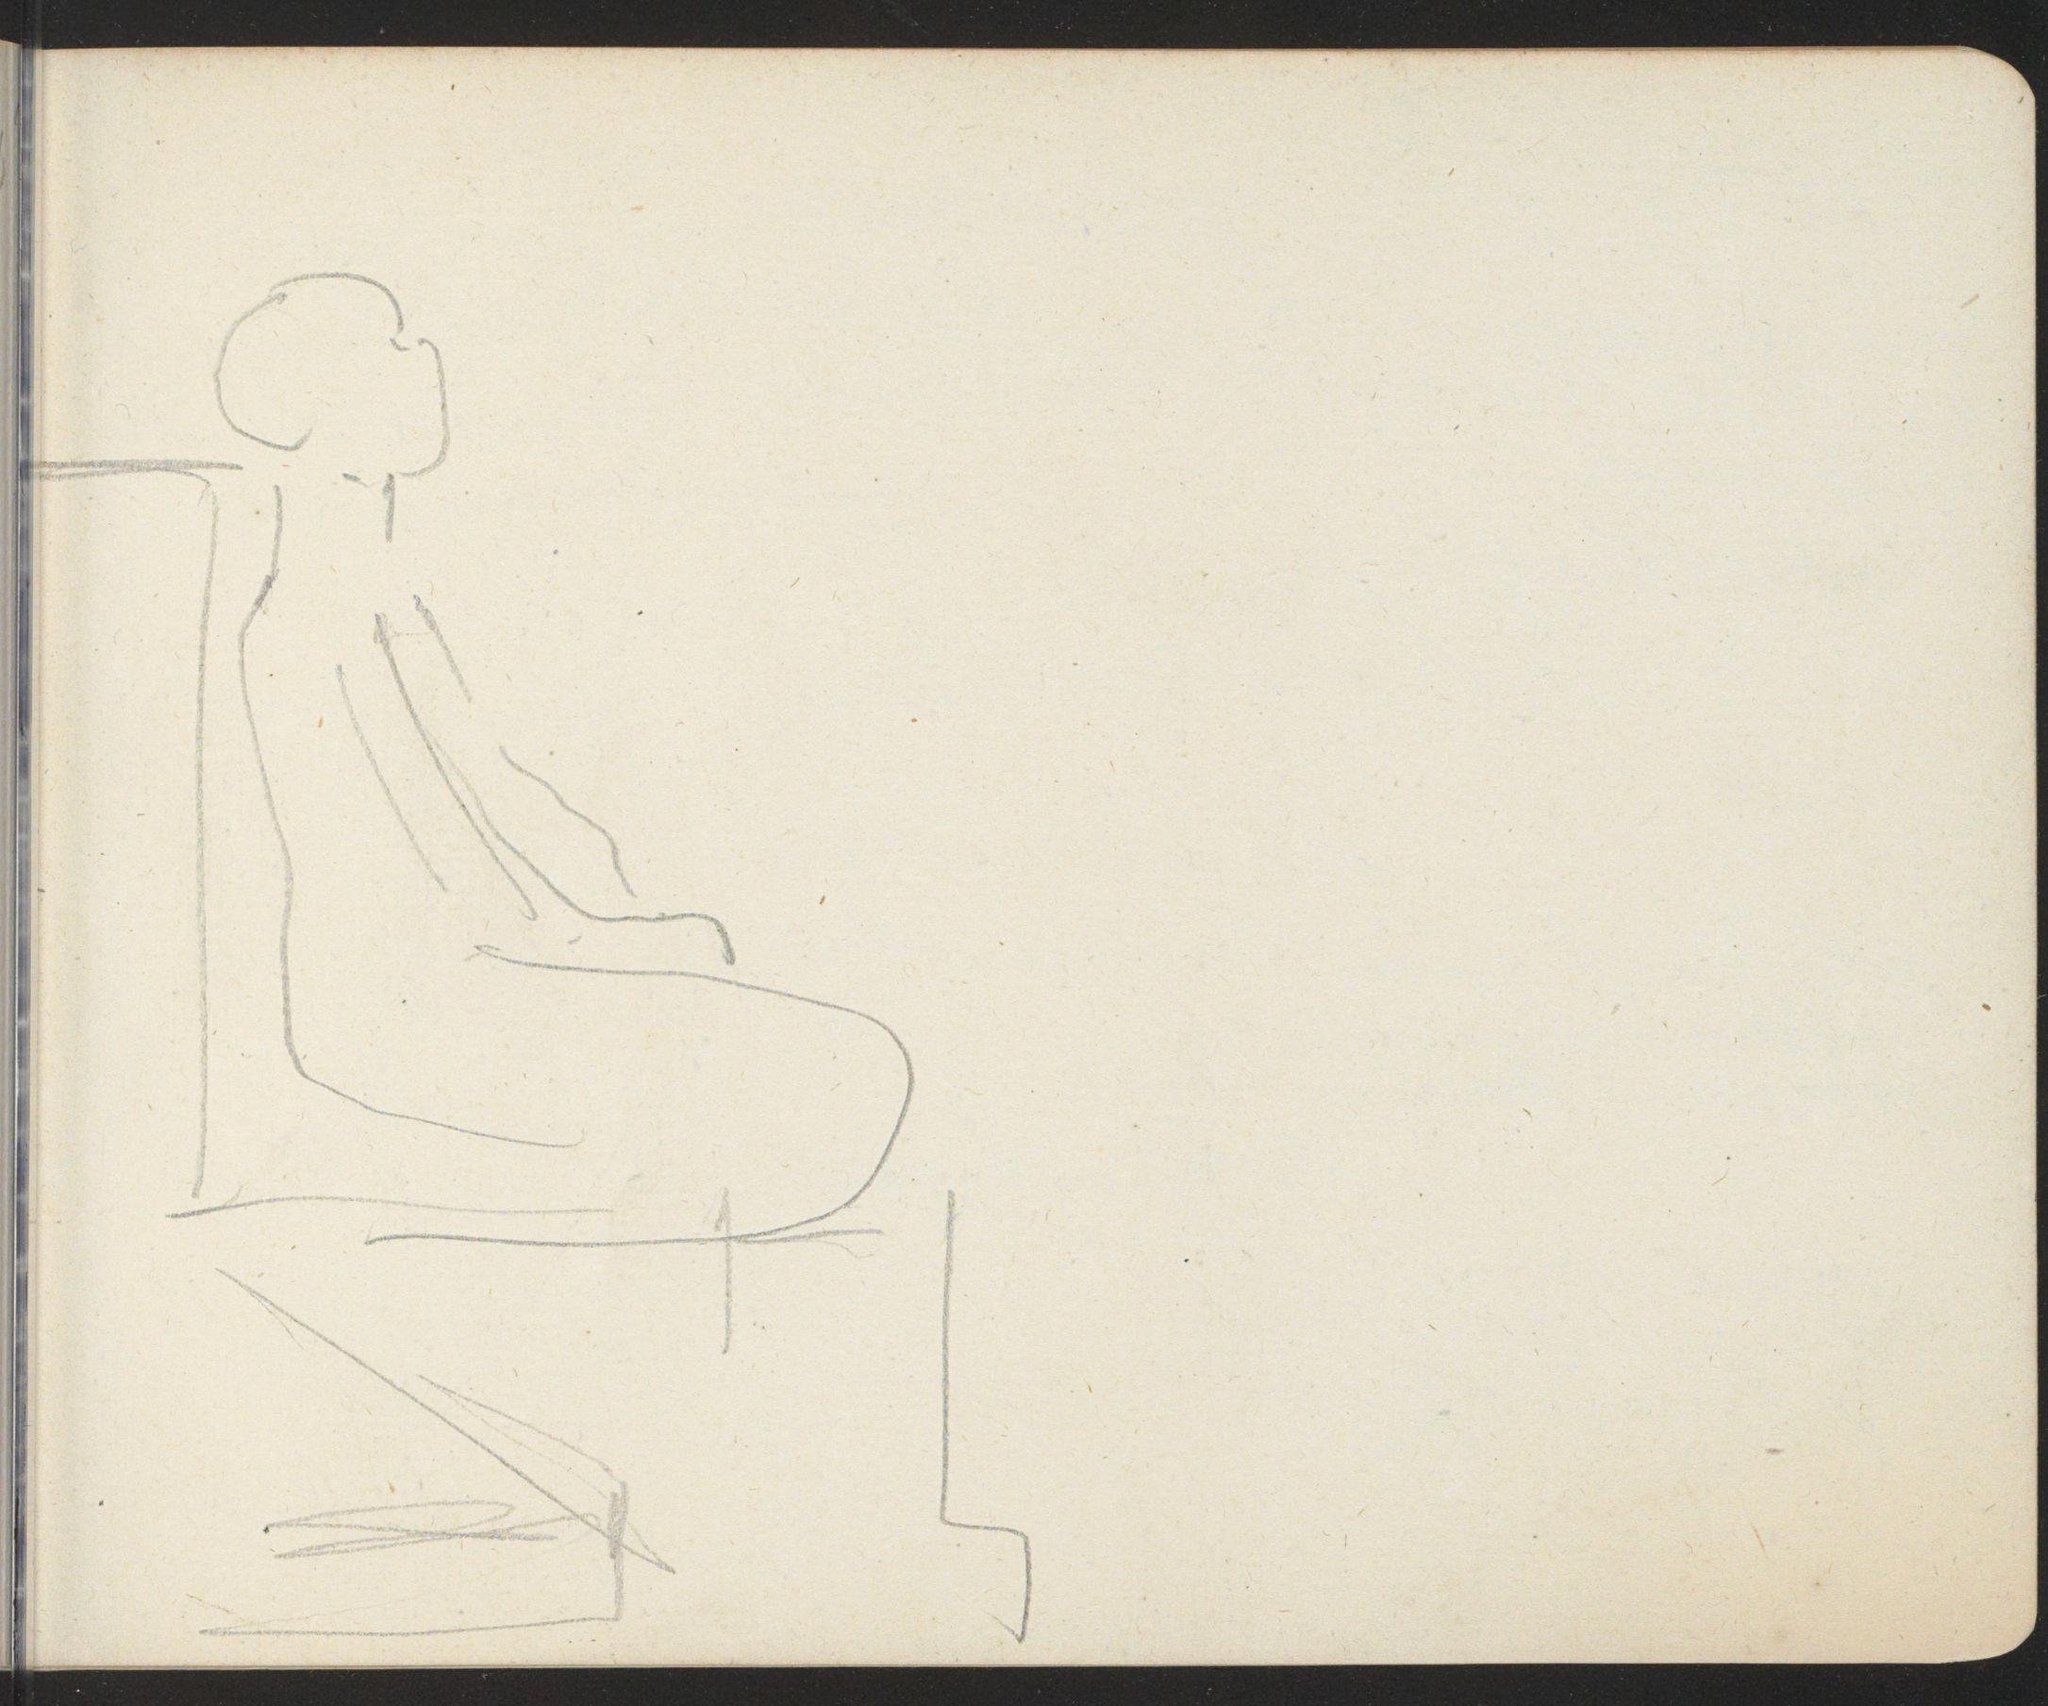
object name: sketchbook leaf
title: Ornament met één zittende figuur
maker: carel adolph lion cachet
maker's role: draughtsman, print maker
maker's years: 1864-1945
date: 1928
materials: paper, pencil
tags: ornaments ~ art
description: Blad 19 recto uit een schetsboek met 24 bladen.